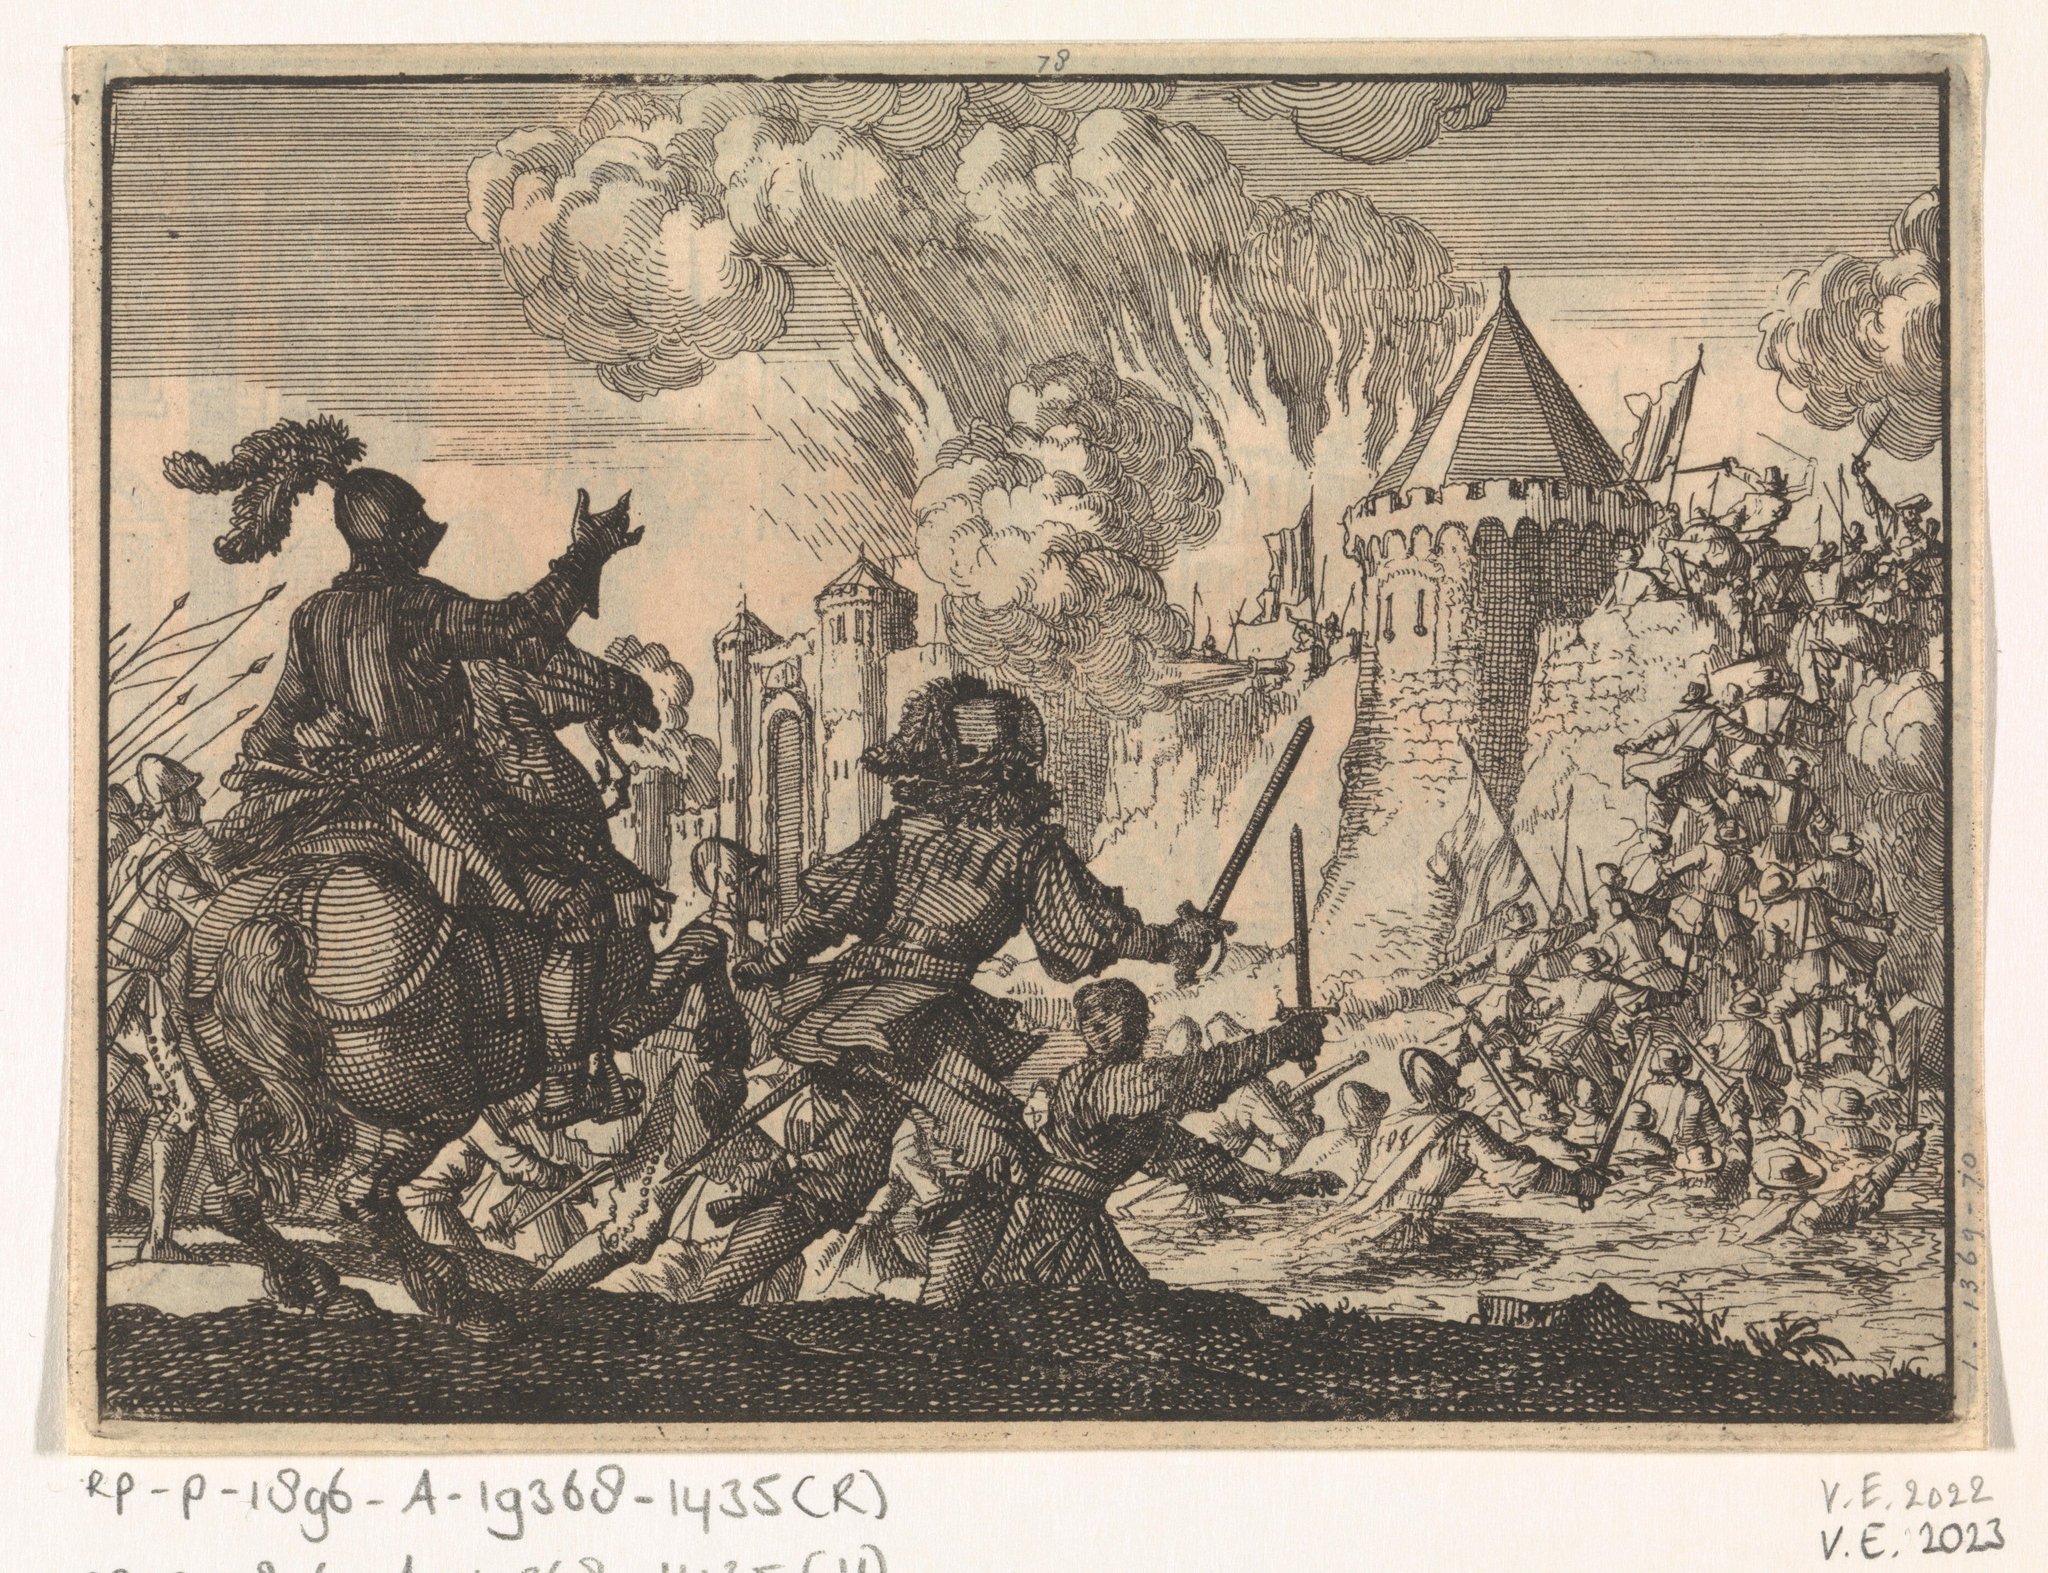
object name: book illustration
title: Hollandse troepen bestormen de muur van Tienen, 1635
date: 1698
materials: paper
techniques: etching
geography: amsterdam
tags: attack ~ siege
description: Illustratie uit: Gottfried, Johann Ludwig. Historische kronyck; vervattende een (...) beschrijvingh der aldergedenckwaerdigste geschiedenissen des weerelds, van den aenvangh der scheppingh tot (...) 1576 (2 delen). Leiden: Pieter van der Aa, 1698, dl. I, p. 1369.